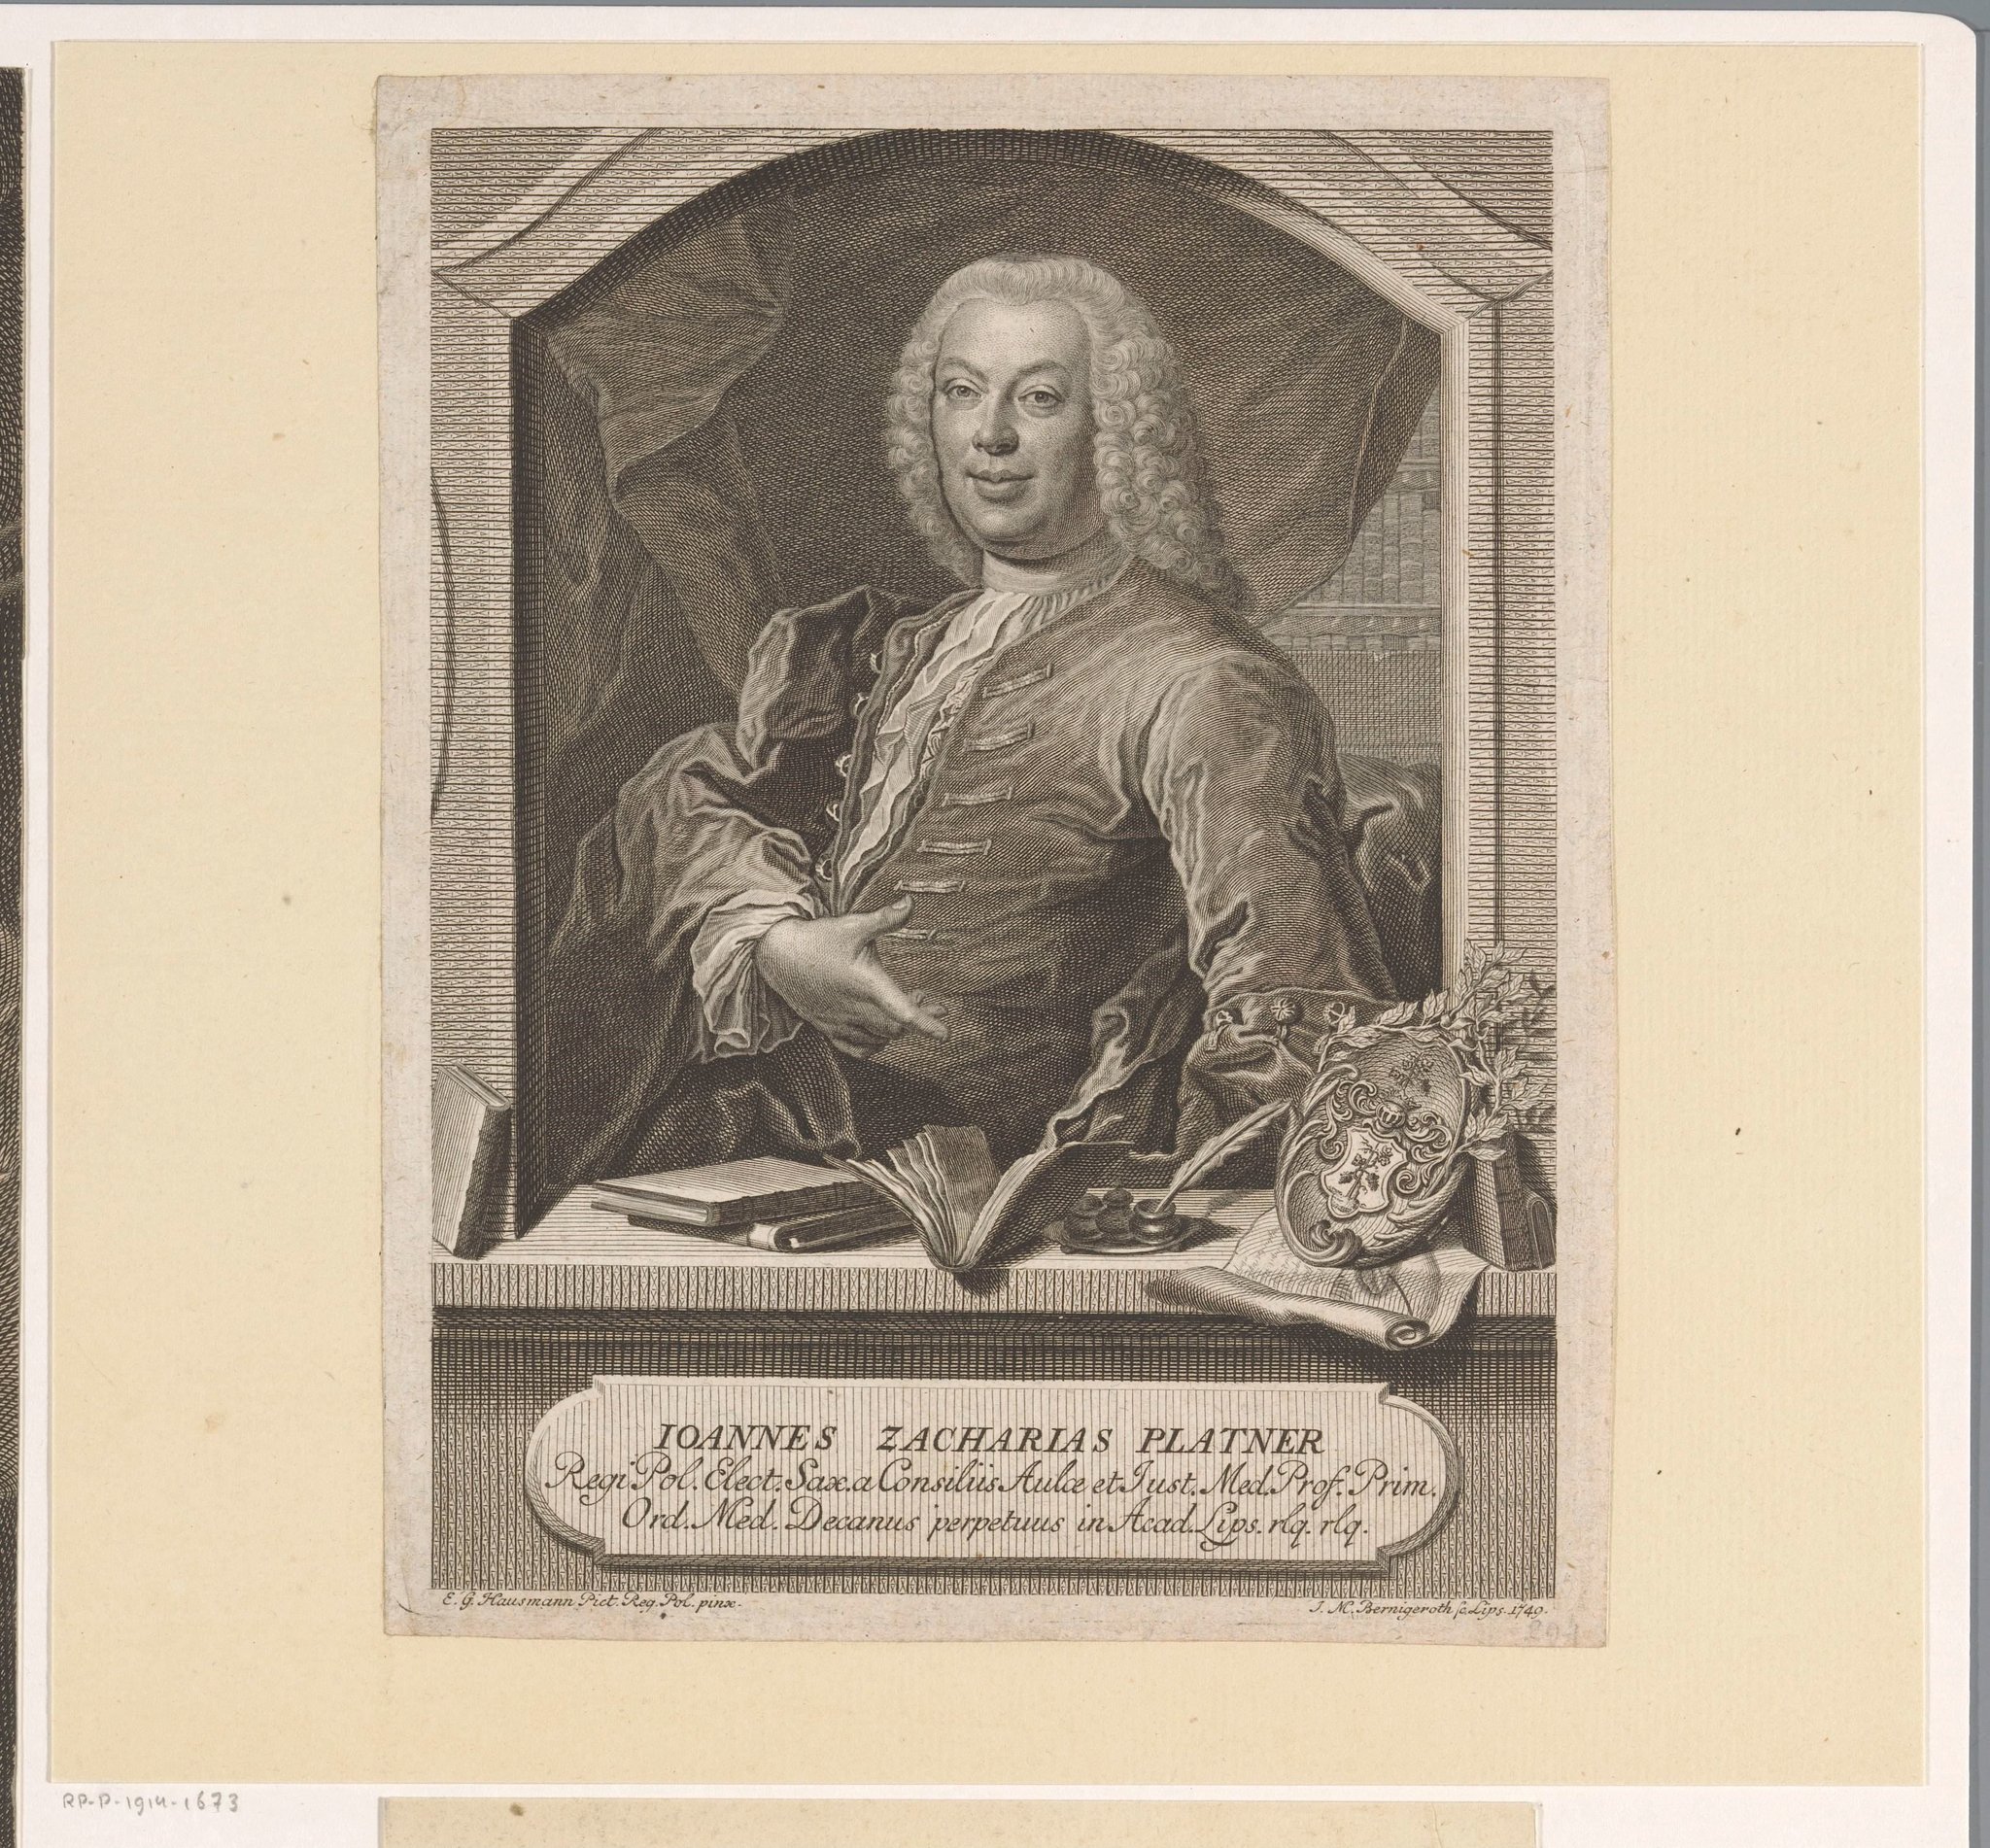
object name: print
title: Portret van Johann Zacharias Platner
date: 1749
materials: paper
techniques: engraving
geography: leipzig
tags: chemnitz, ink-well, historical persons, book, armorial bearing, heraldry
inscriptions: date